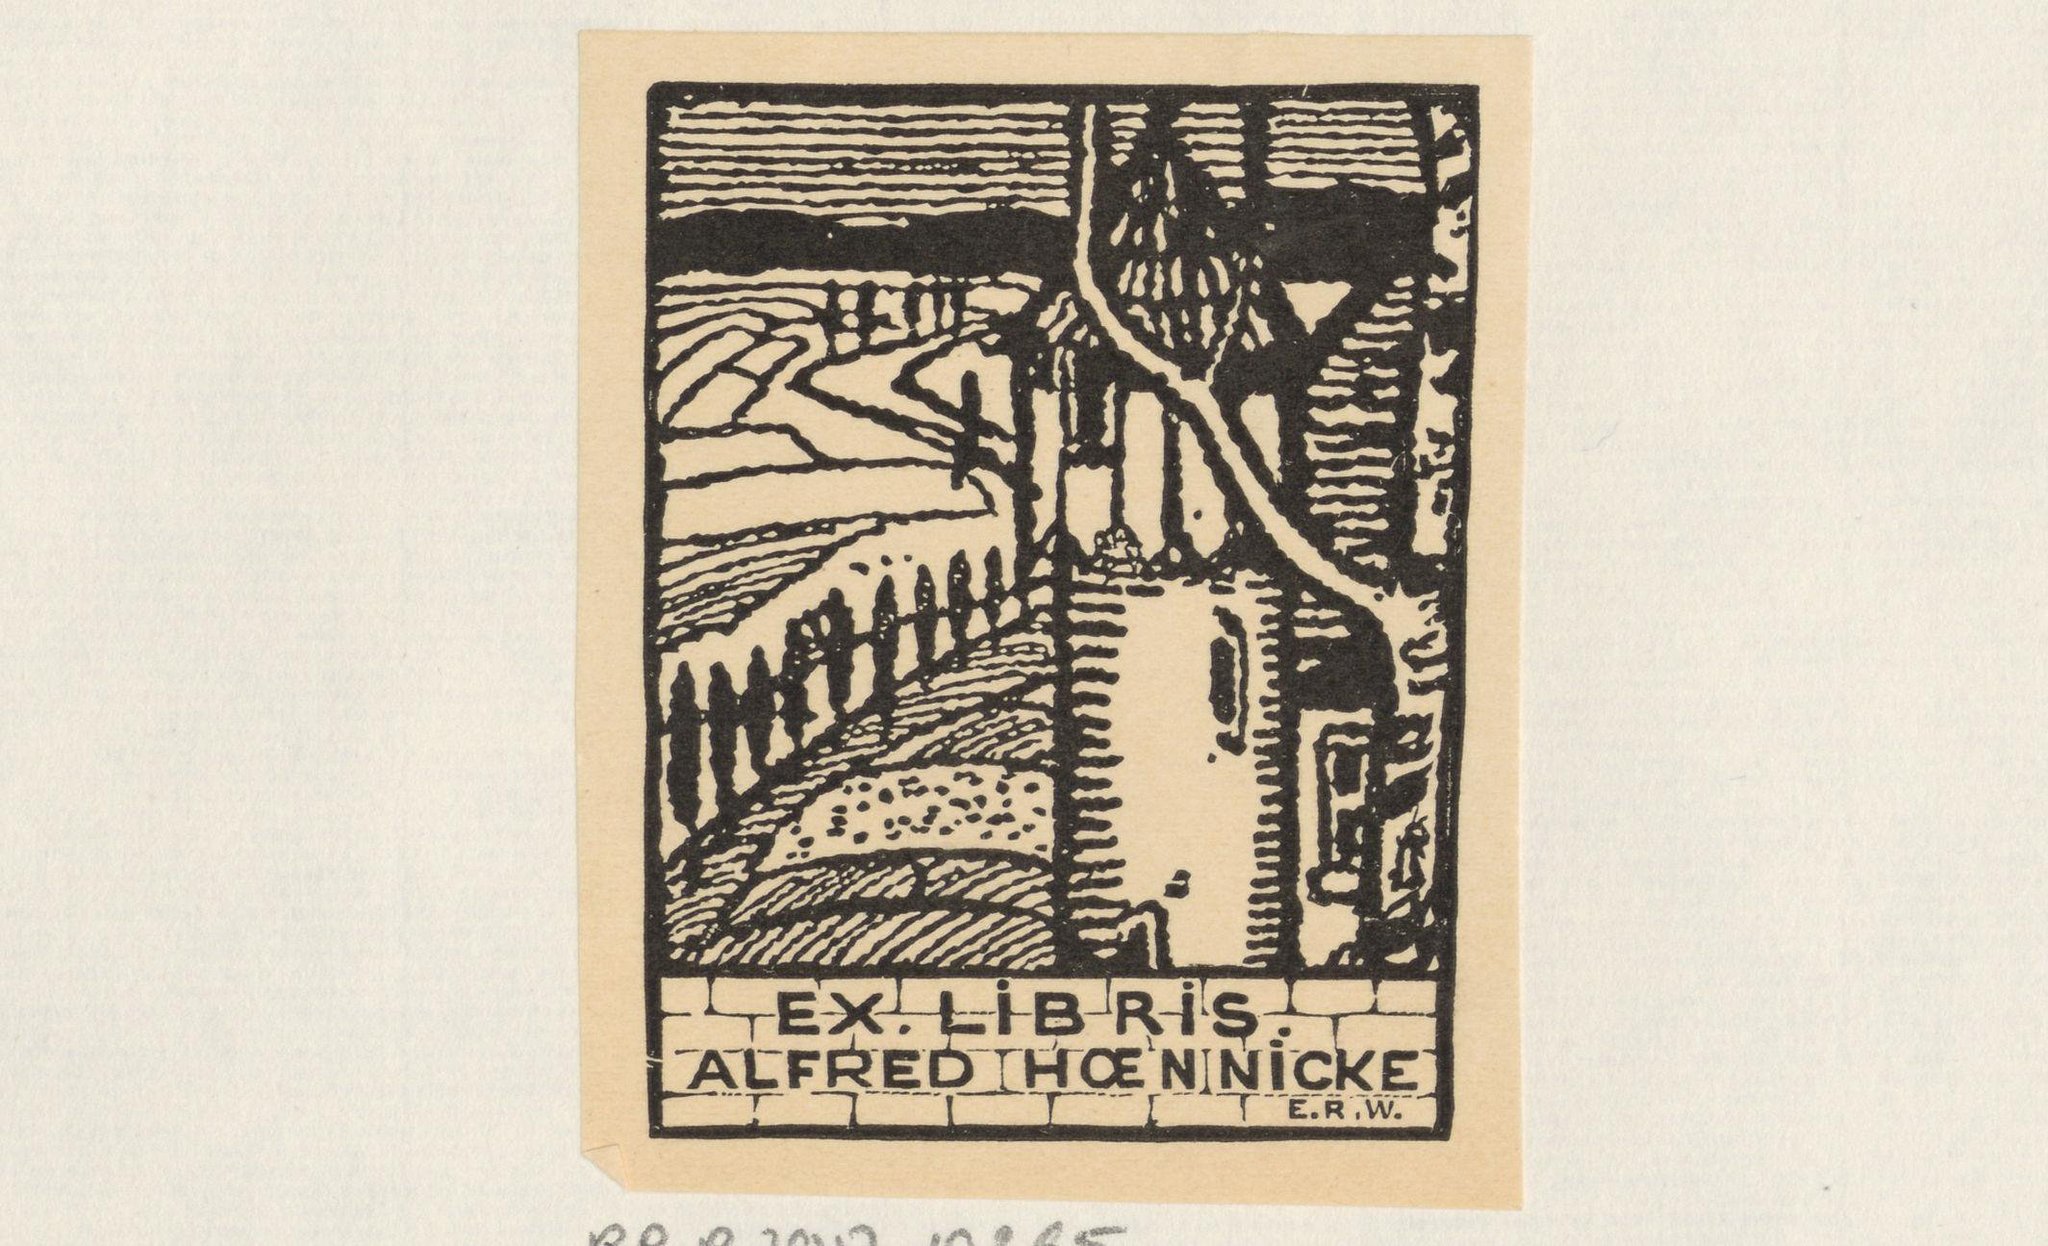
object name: bookplate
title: Ex libris van Alfred Hoennicke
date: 1885-1942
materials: paper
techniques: printing block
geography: germany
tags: printer, castle, saints, trees: birch